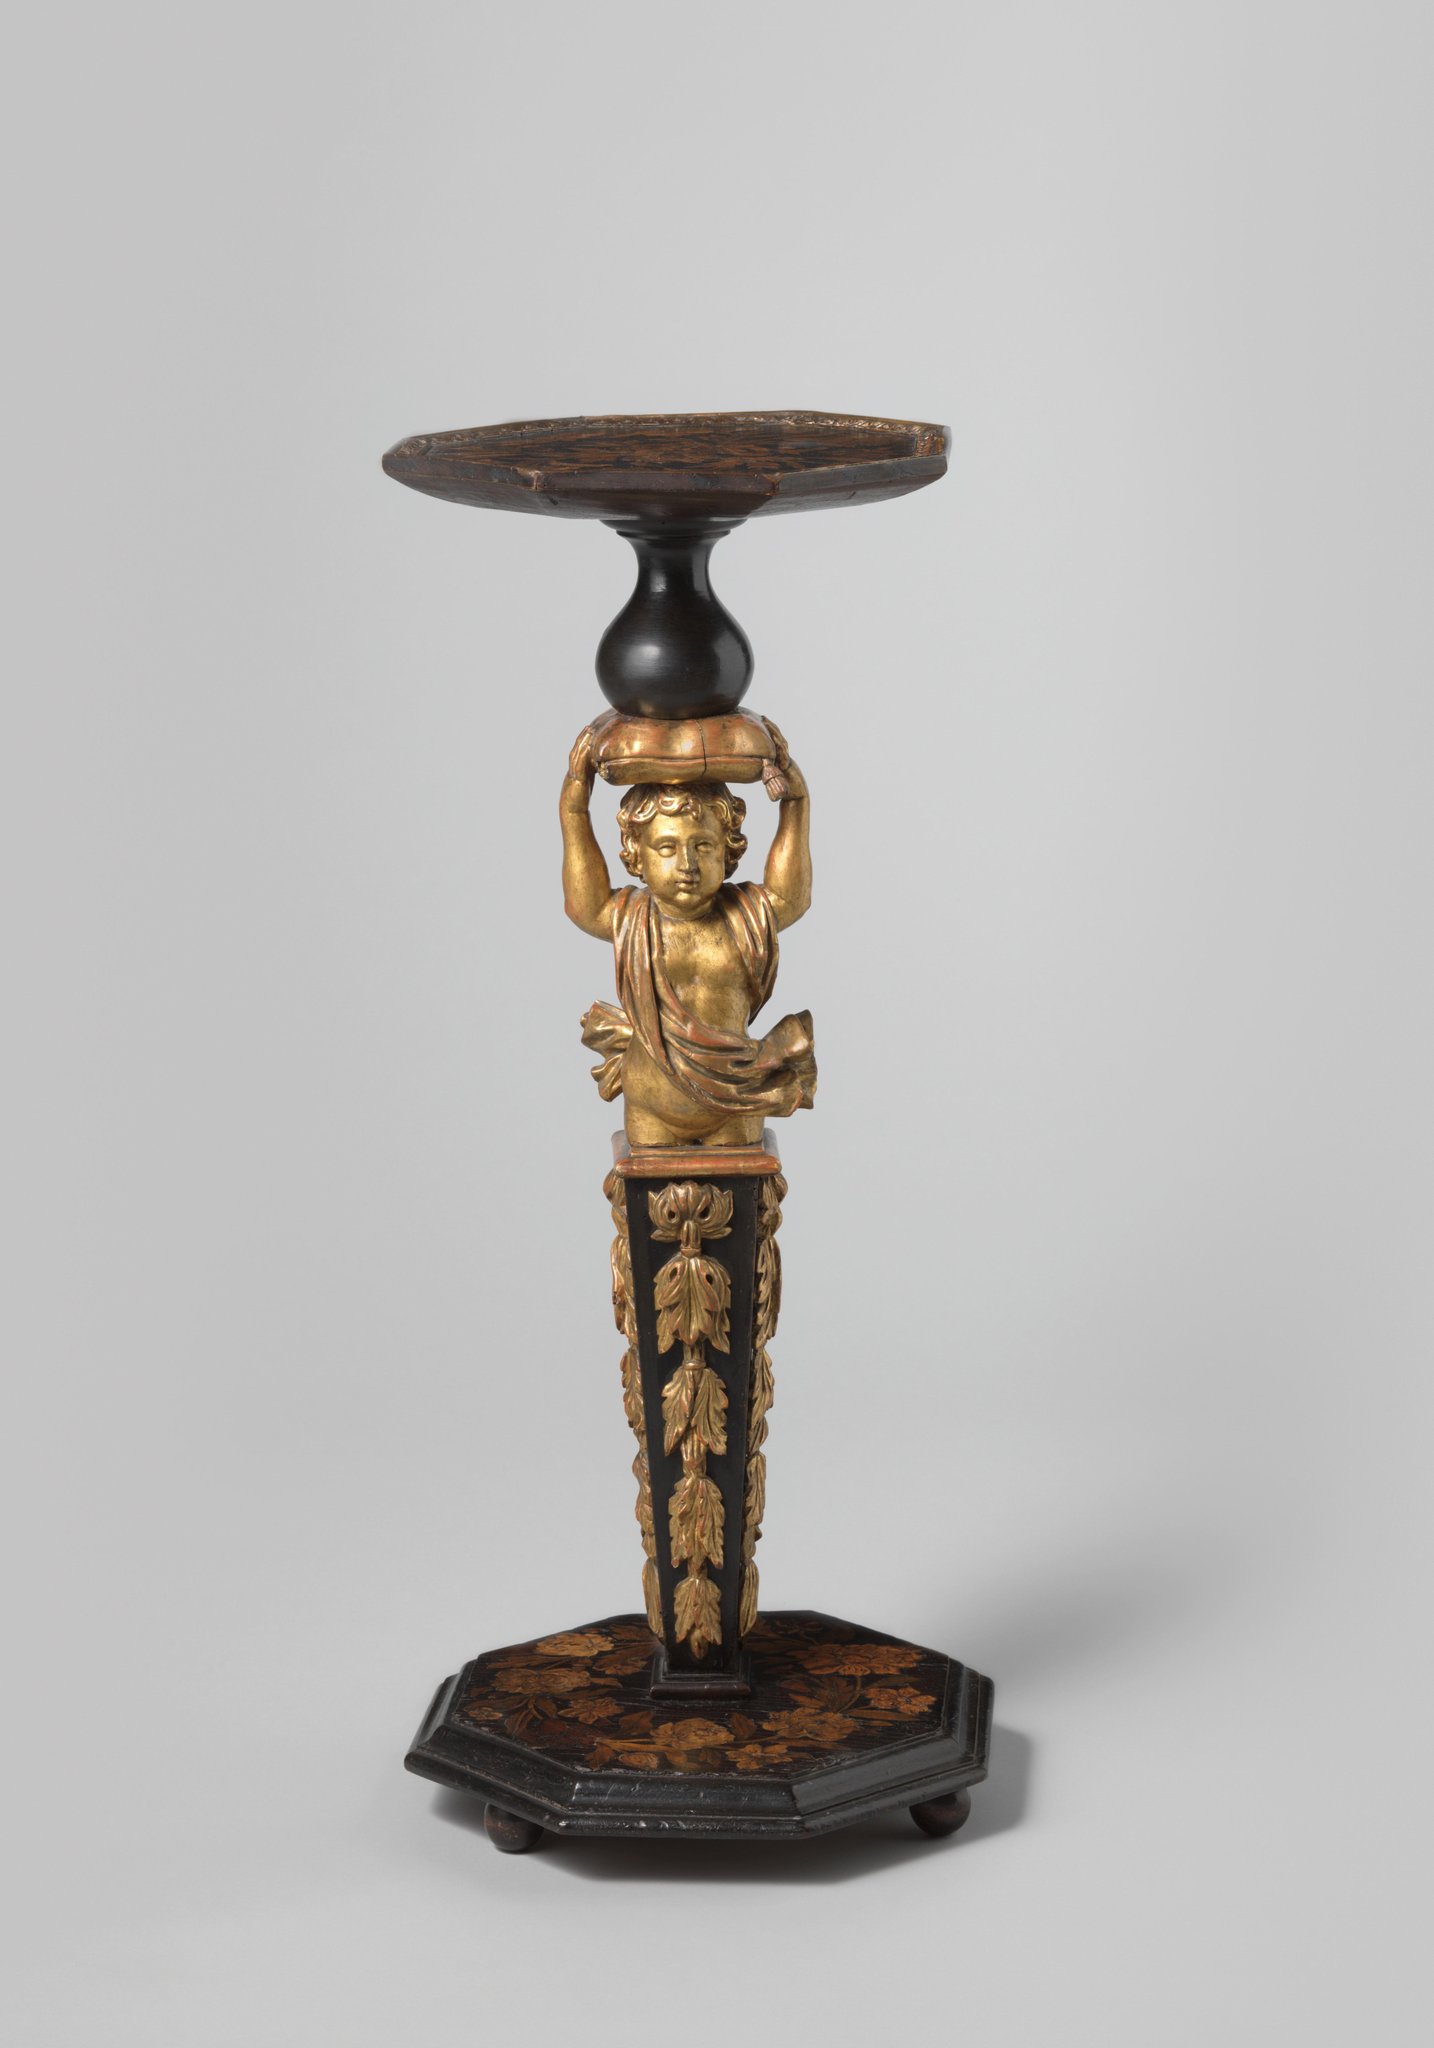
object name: furniture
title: Gueridon versierd met marqueterie. Schacht met een putto die met de handen een op het hoofd gedragen kussen steunt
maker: Anonymous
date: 1700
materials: wood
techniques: gilding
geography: netherlands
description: Een gueridon versierd met marqueterie van palissander-, satijn-, olijvehout en andere houtsoorten, gedeeltelijk verguld en zwart geschilderd. De stam bestaat uit een hermvormige schacht versierd met gestoken bladeren, waarboven een putto die met de handen een op het hoofd gedragen kussen steunt. Op het kussen rust, op een peervormig tussenstuk, een achthoekig blad met gestoken bladrand en met vlinder en bloemen versierd. Het achthoekige voetstuk heeft bloemenversiering in marqueterie. Pendant: BK-16076-a.